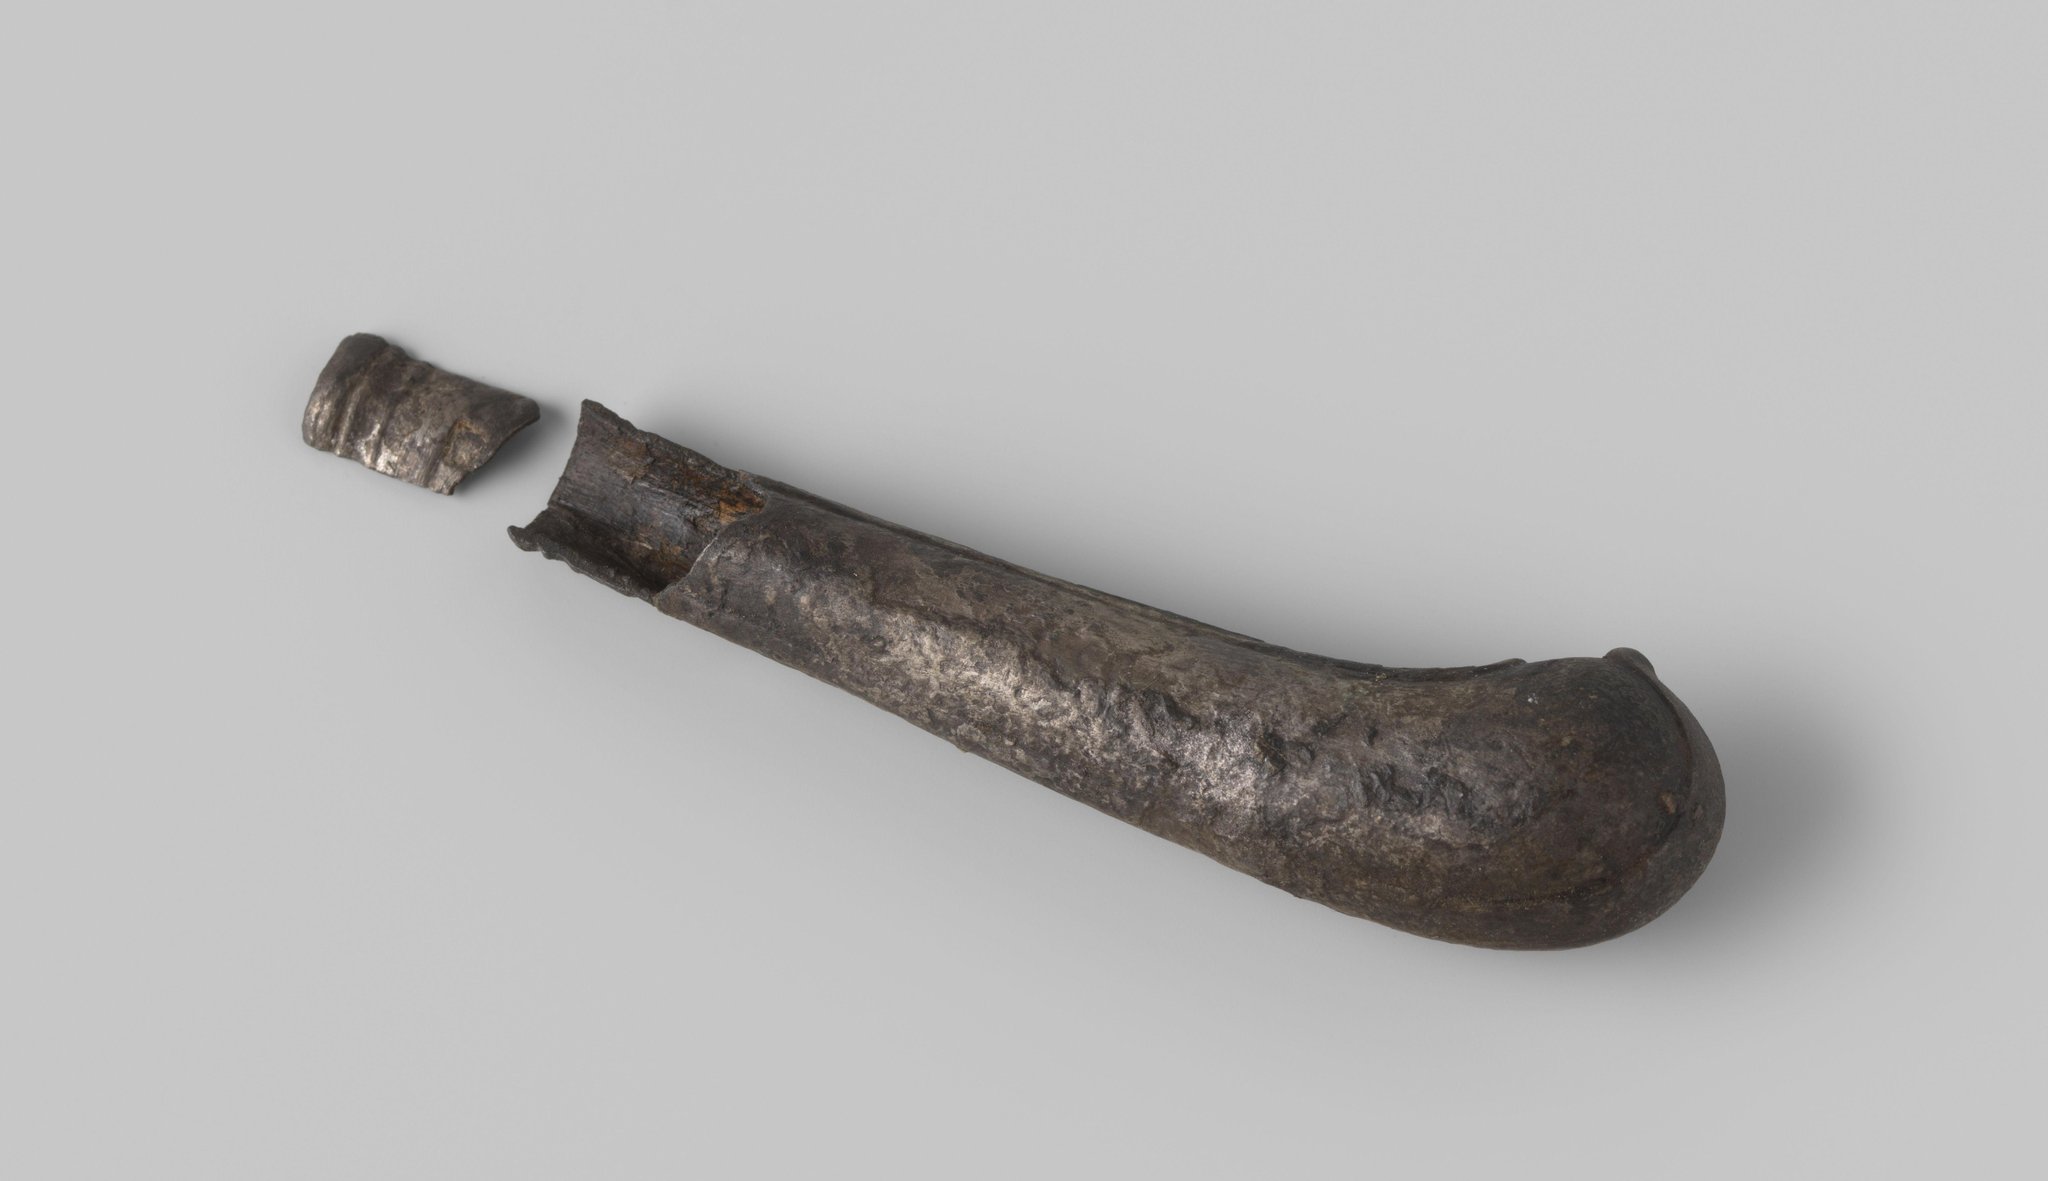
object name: knife tool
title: Fragmenten mes uit het wrak van de Oost-Indiëvaarder Hollandia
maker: Anonymous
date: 1700-1743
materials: silver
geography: netherlands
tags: verenigde oostindische compagnie, hollandia (schip), annet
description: Cutlery, knive; fragm, id. NG 1980-27H733, with id. coat of arms.